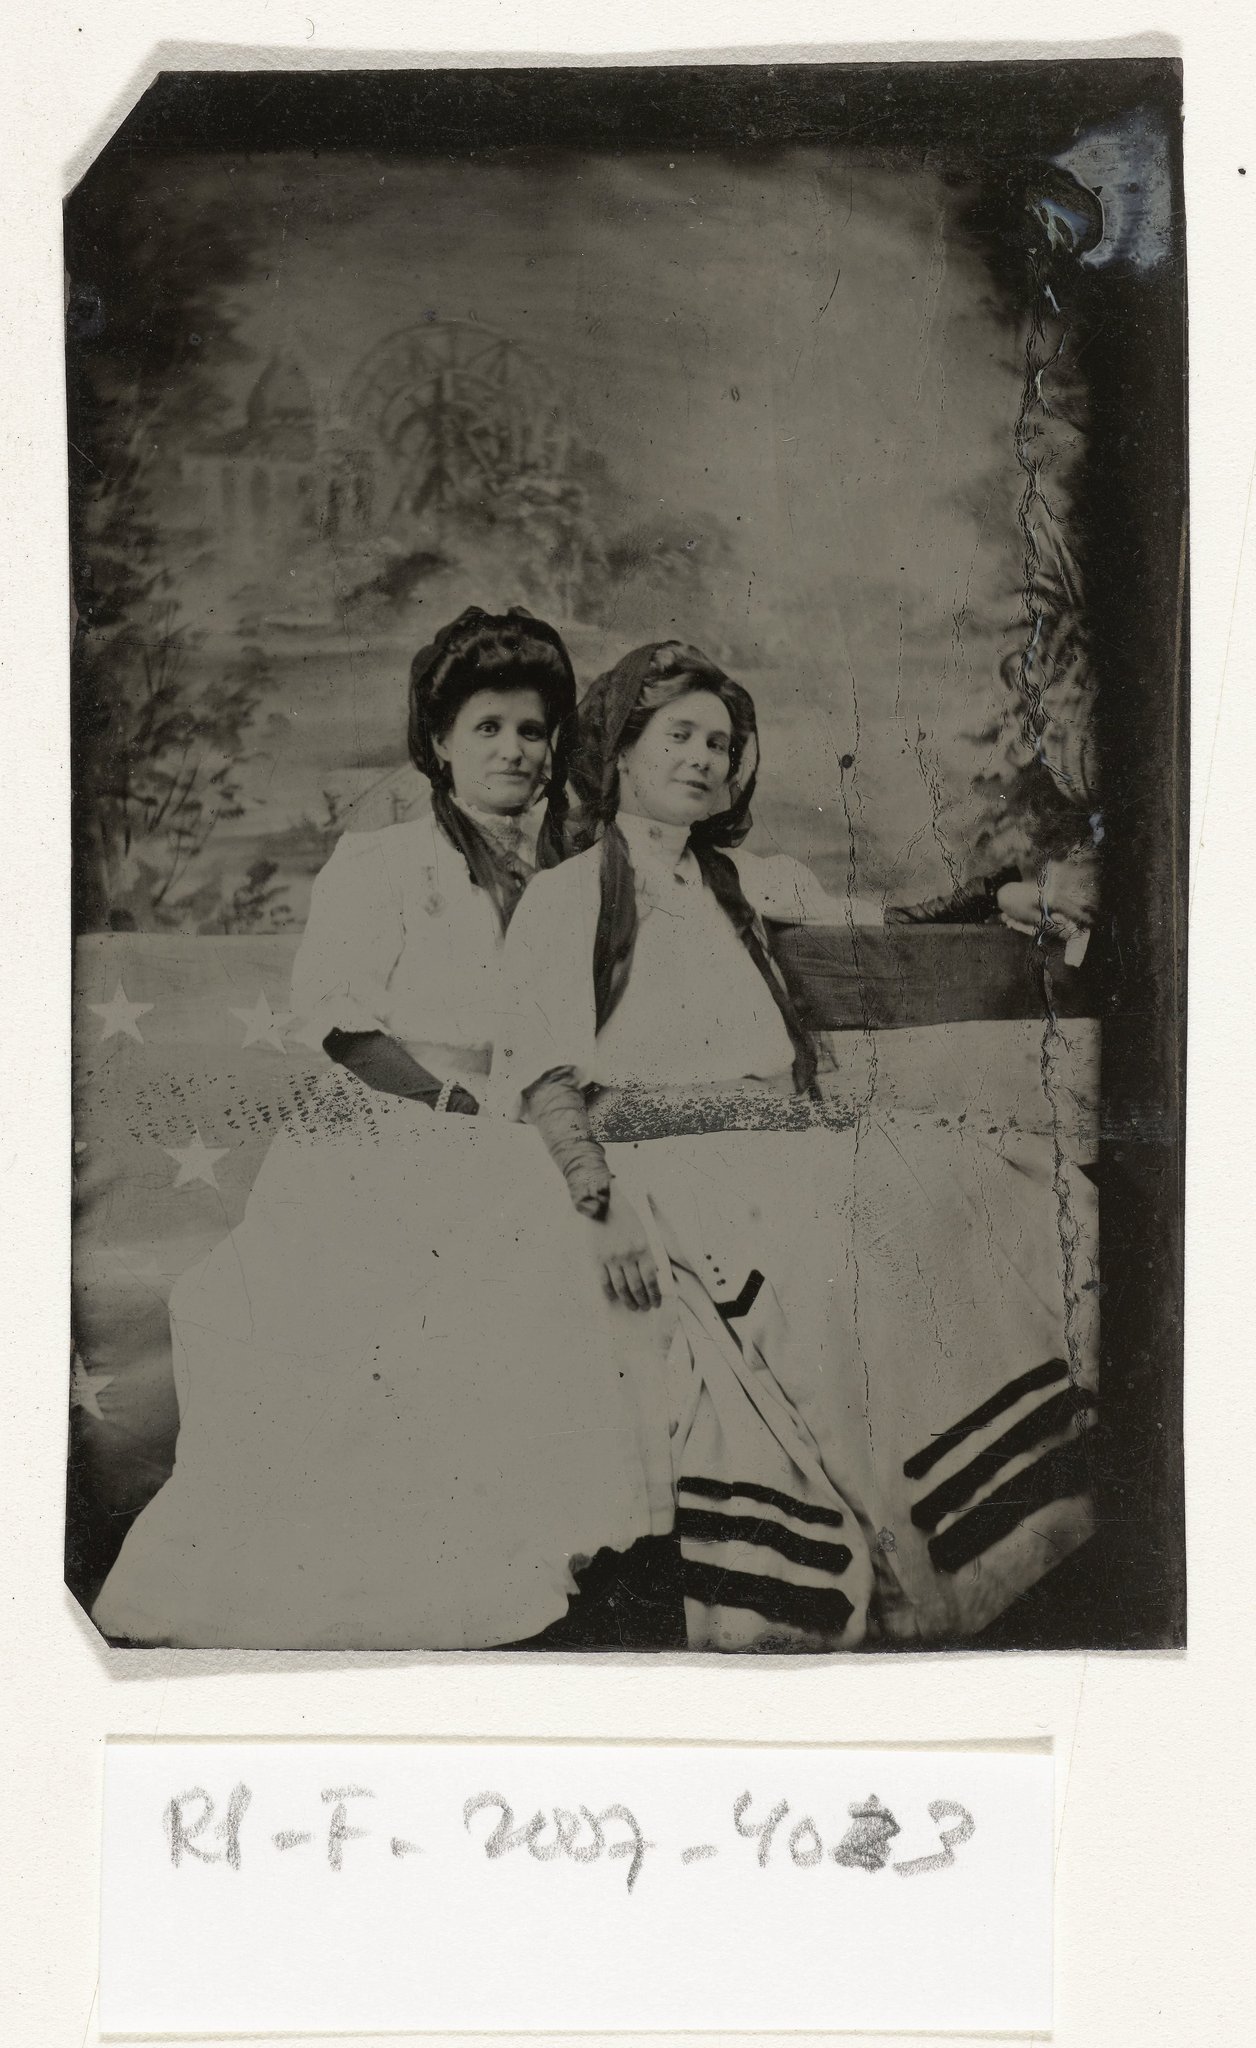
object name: photograph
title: Portrait of two women sitting on a bench in front of a painted backdrop (chapel or church (?) by a lake), with a part of the American flag on the left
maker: Anonymous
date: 1880-1910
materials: metal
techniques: ferrotyping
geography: united states